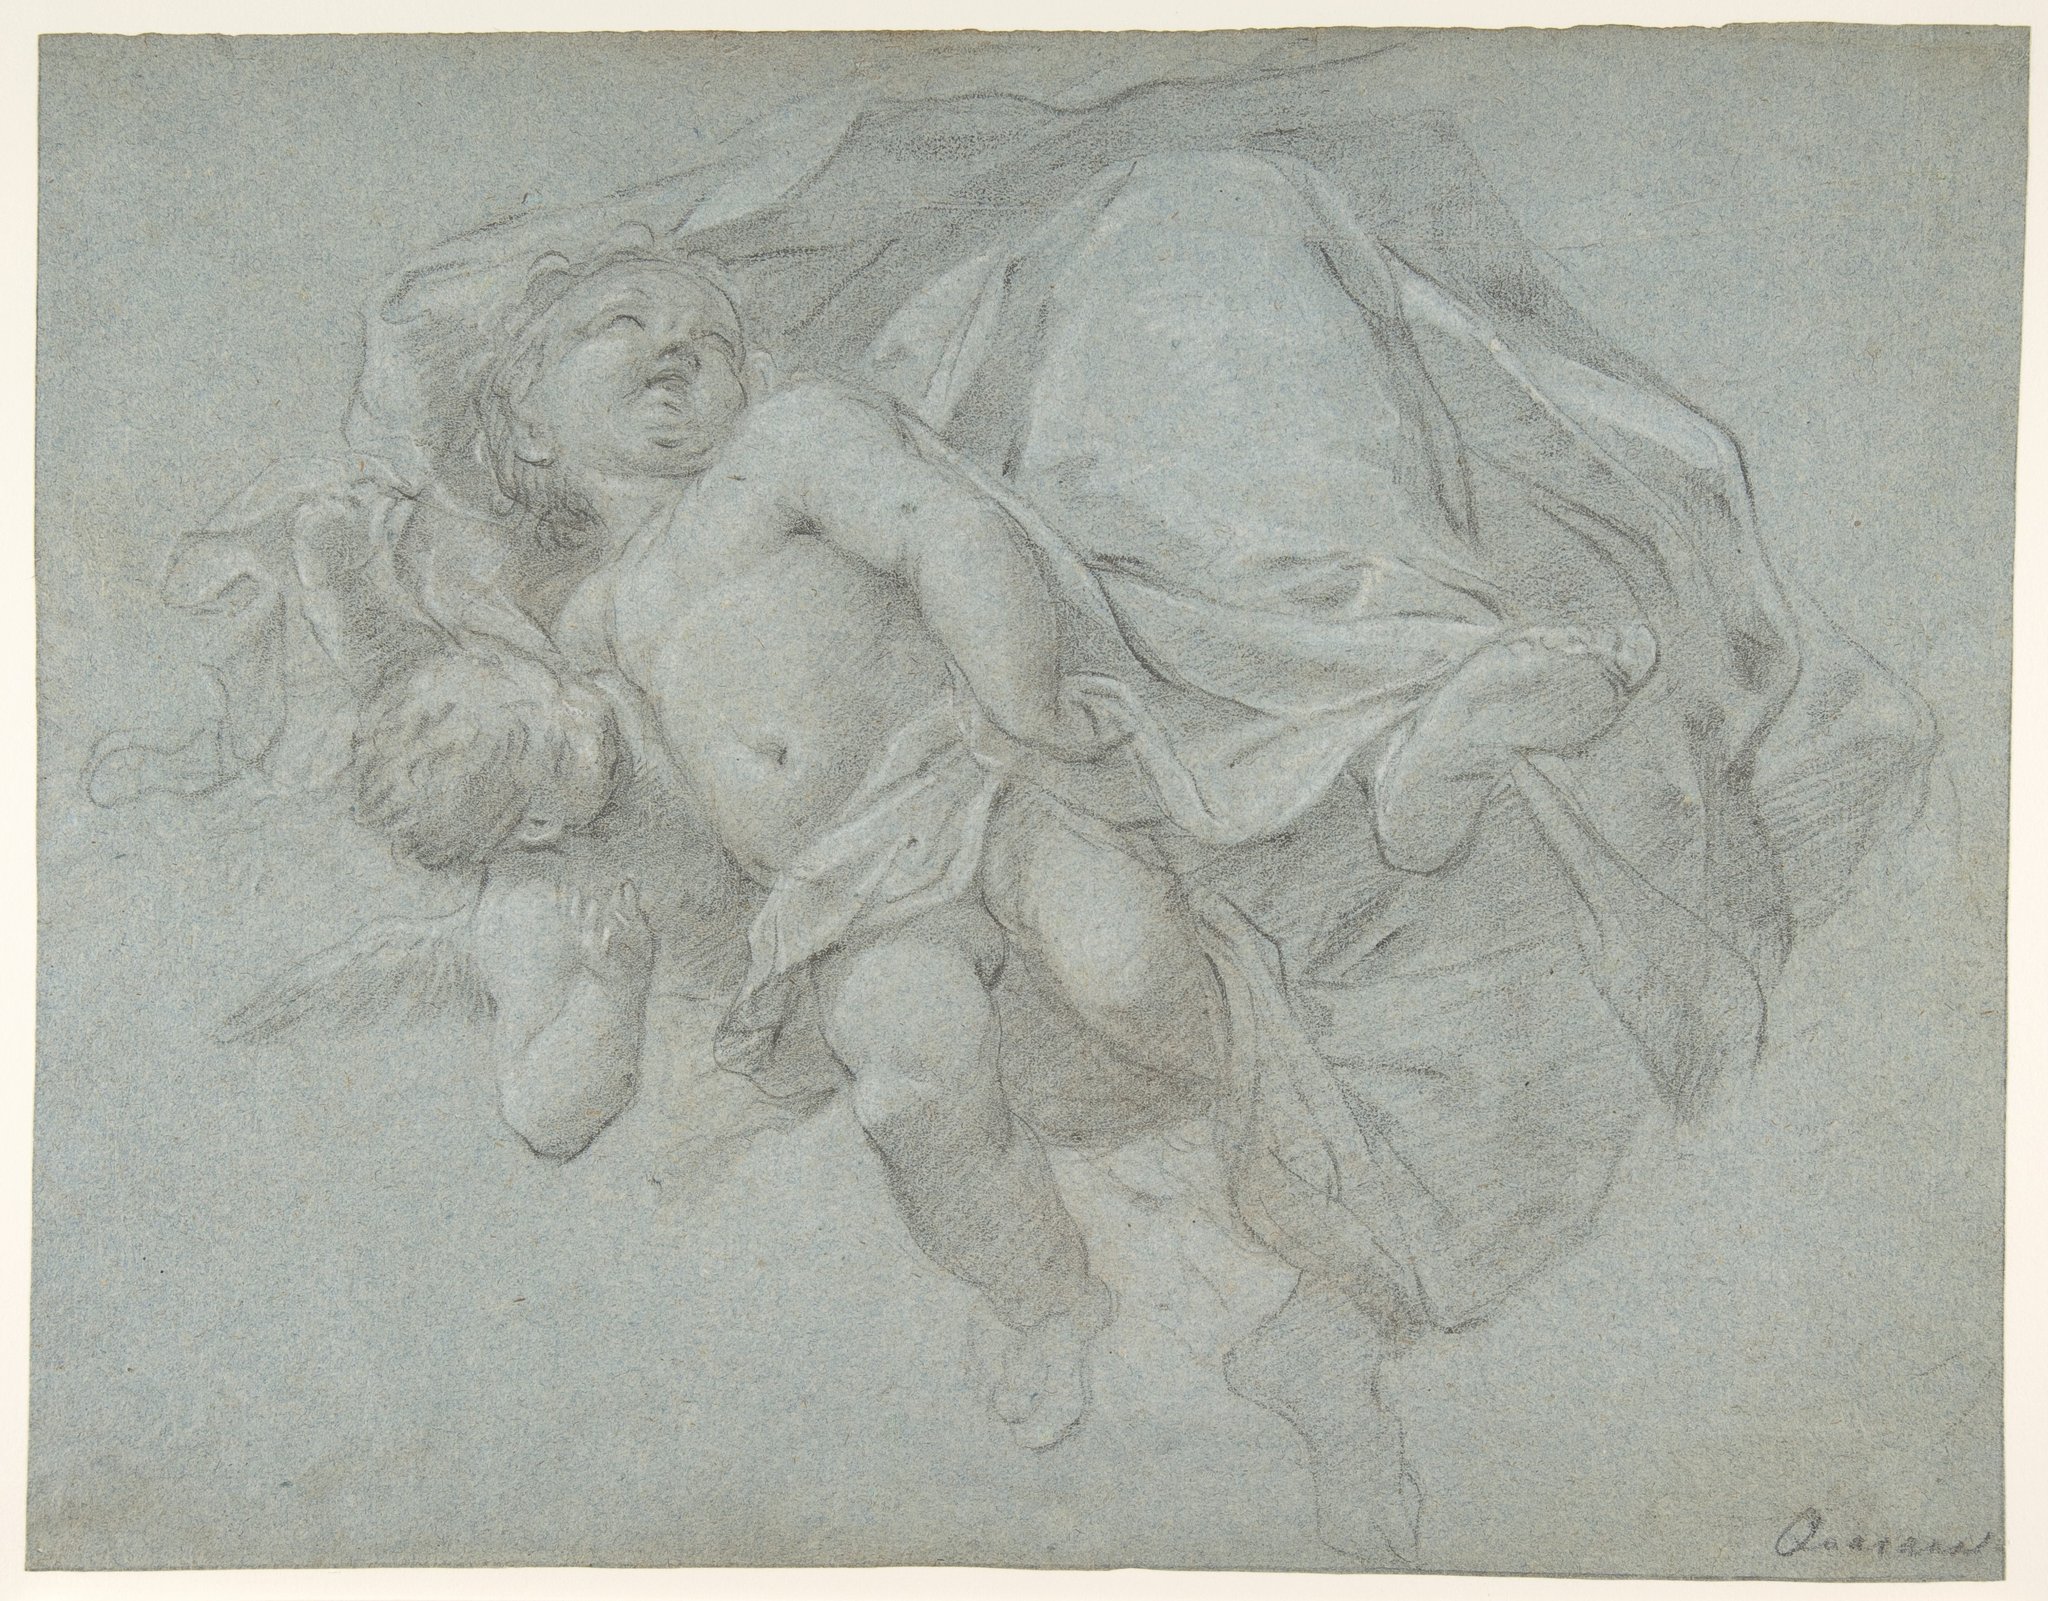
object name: drawing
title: Two Putti Supporting the Lower Part of a Draped Figure (recto); Two Putti (verso)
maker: jacopo guarana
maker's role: artist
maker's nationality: italian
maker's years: 1720-1808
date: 1720-1808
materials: chalk, paper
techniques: highlighting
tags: putti